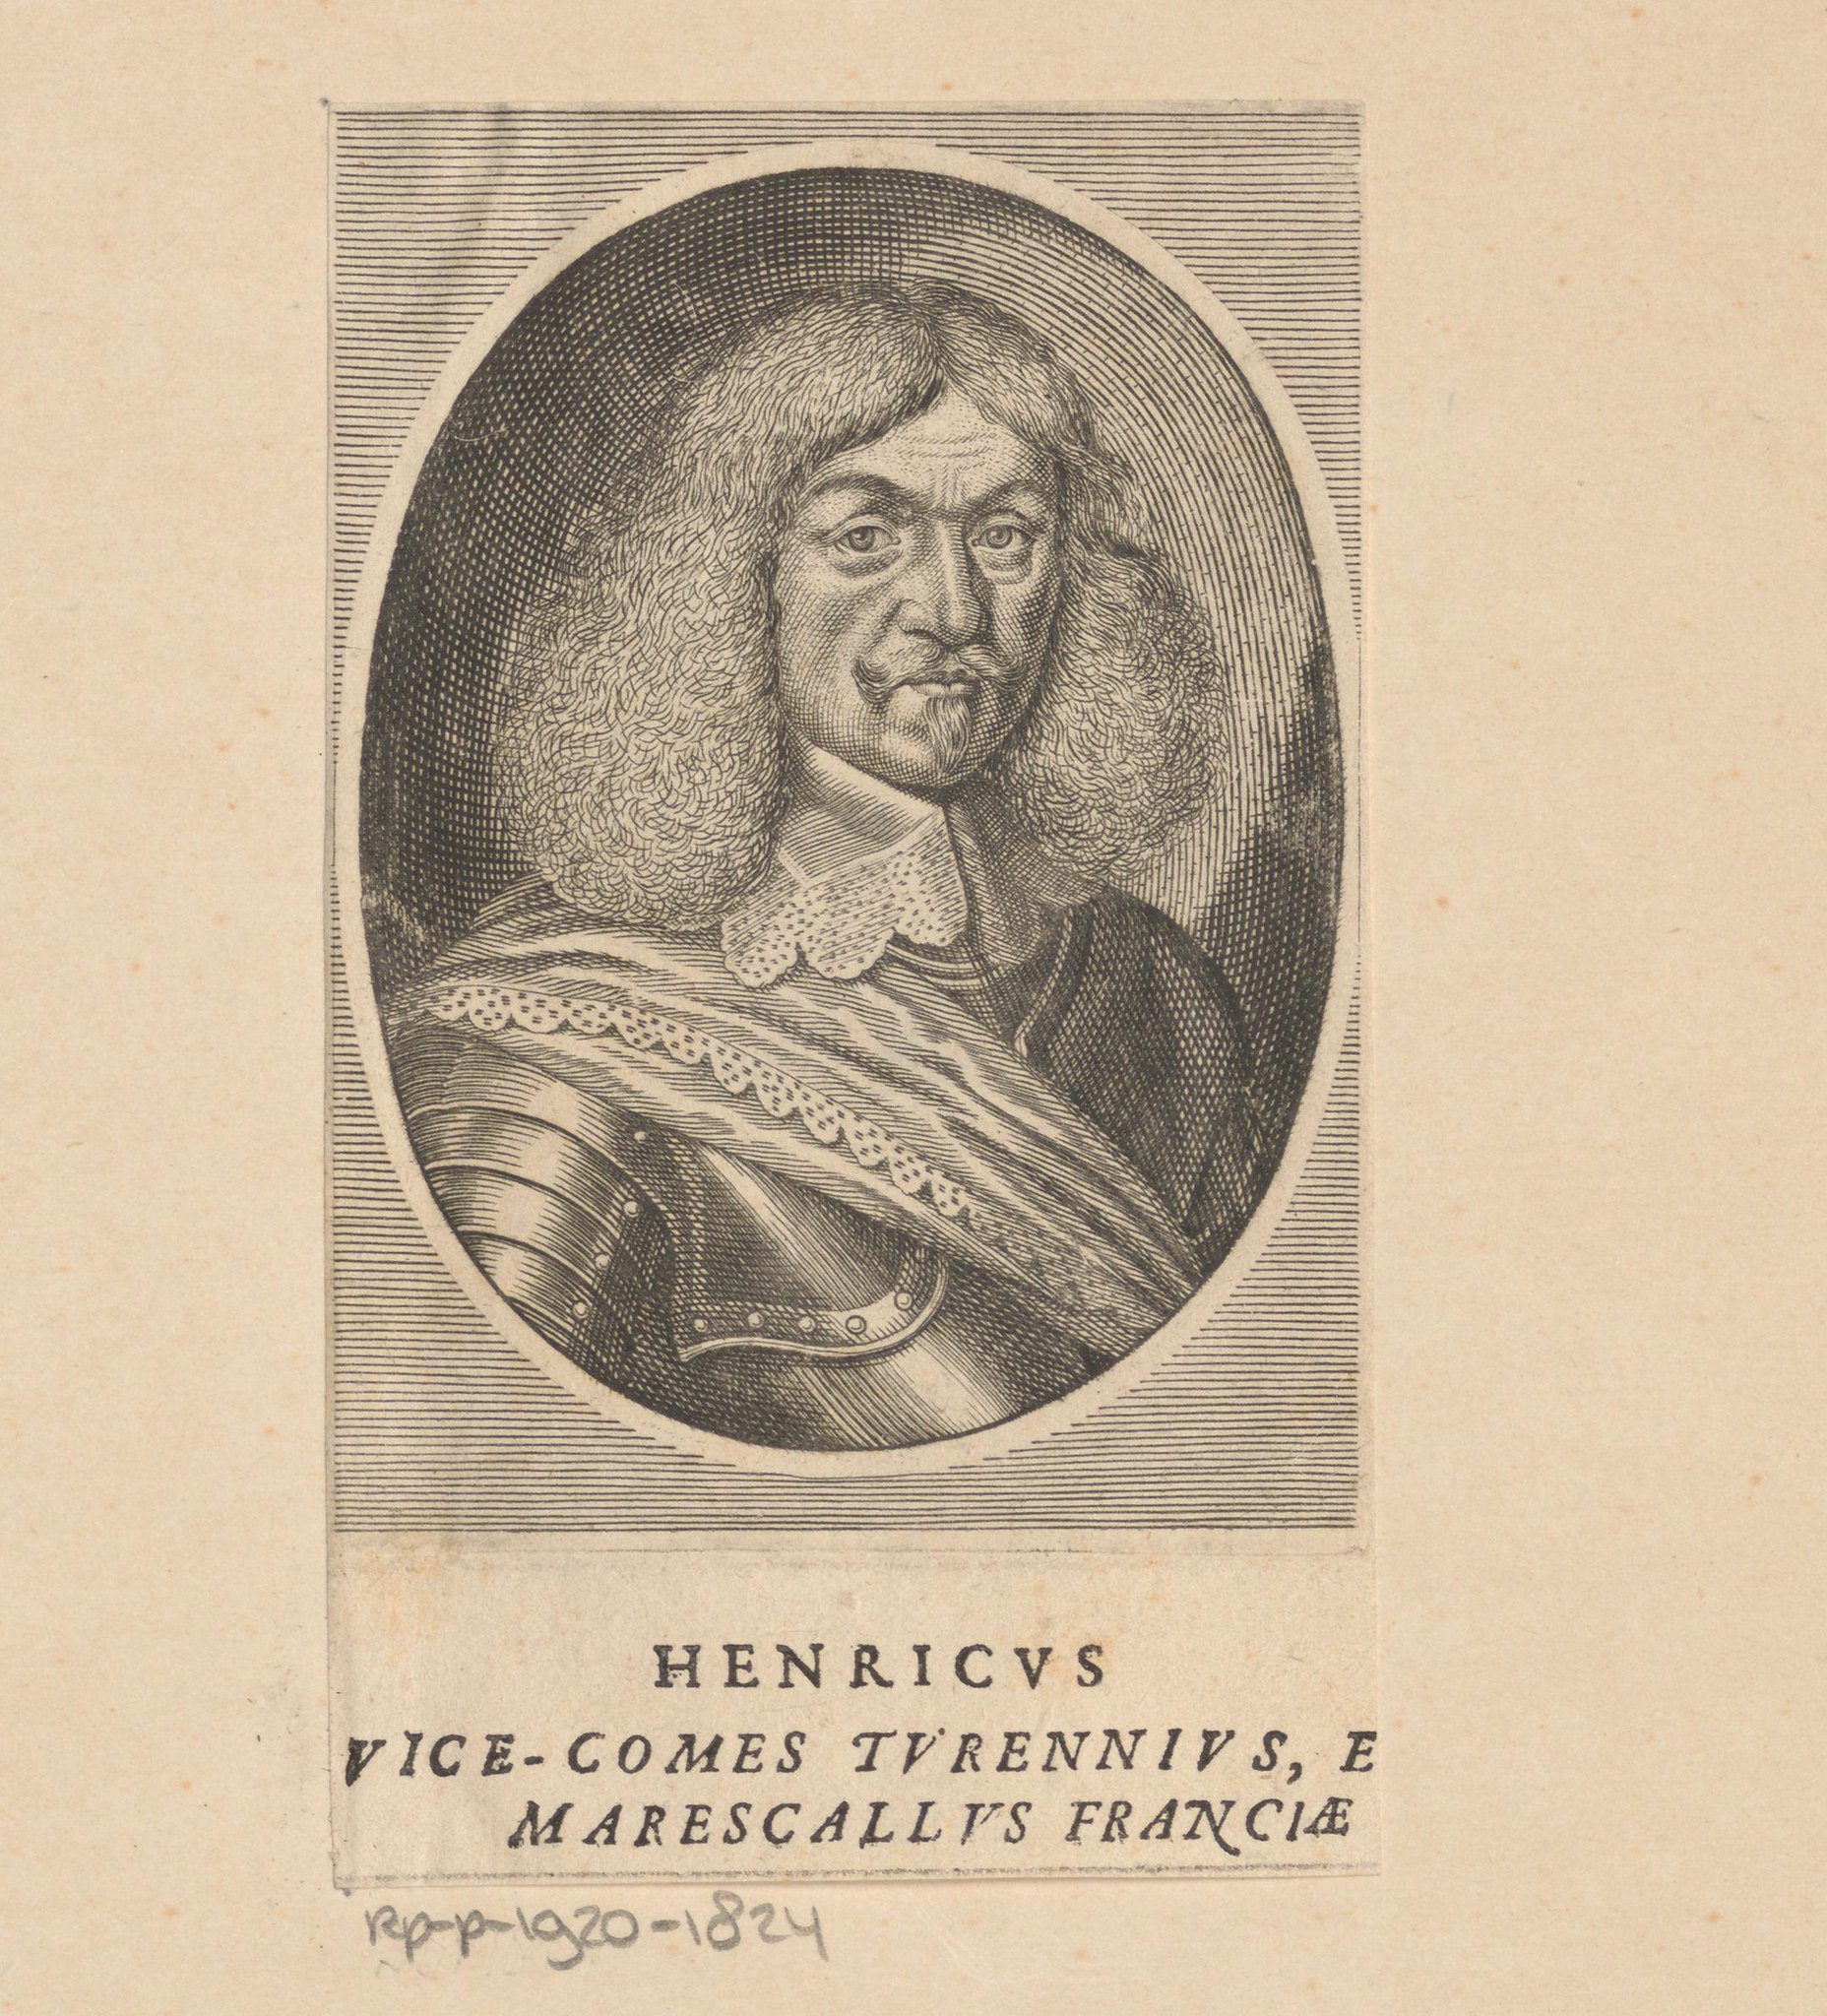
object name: print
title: Portret van Henri de La Tour d'Auvergne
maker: Anonymous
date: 1657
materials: paper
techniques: engraving, etching, letterpress printing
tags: commander-in-chief, general, marshal, armour, historical persons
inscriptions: collector's mark: Lugt 2228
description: Prent waarschijnlijk uit: Thülden, Christian Adolph. Historiae nostri temporis ab Anno Christi 1652 usque ad 1657. Keulen: Johannes Antonius Kinchius, 1657.